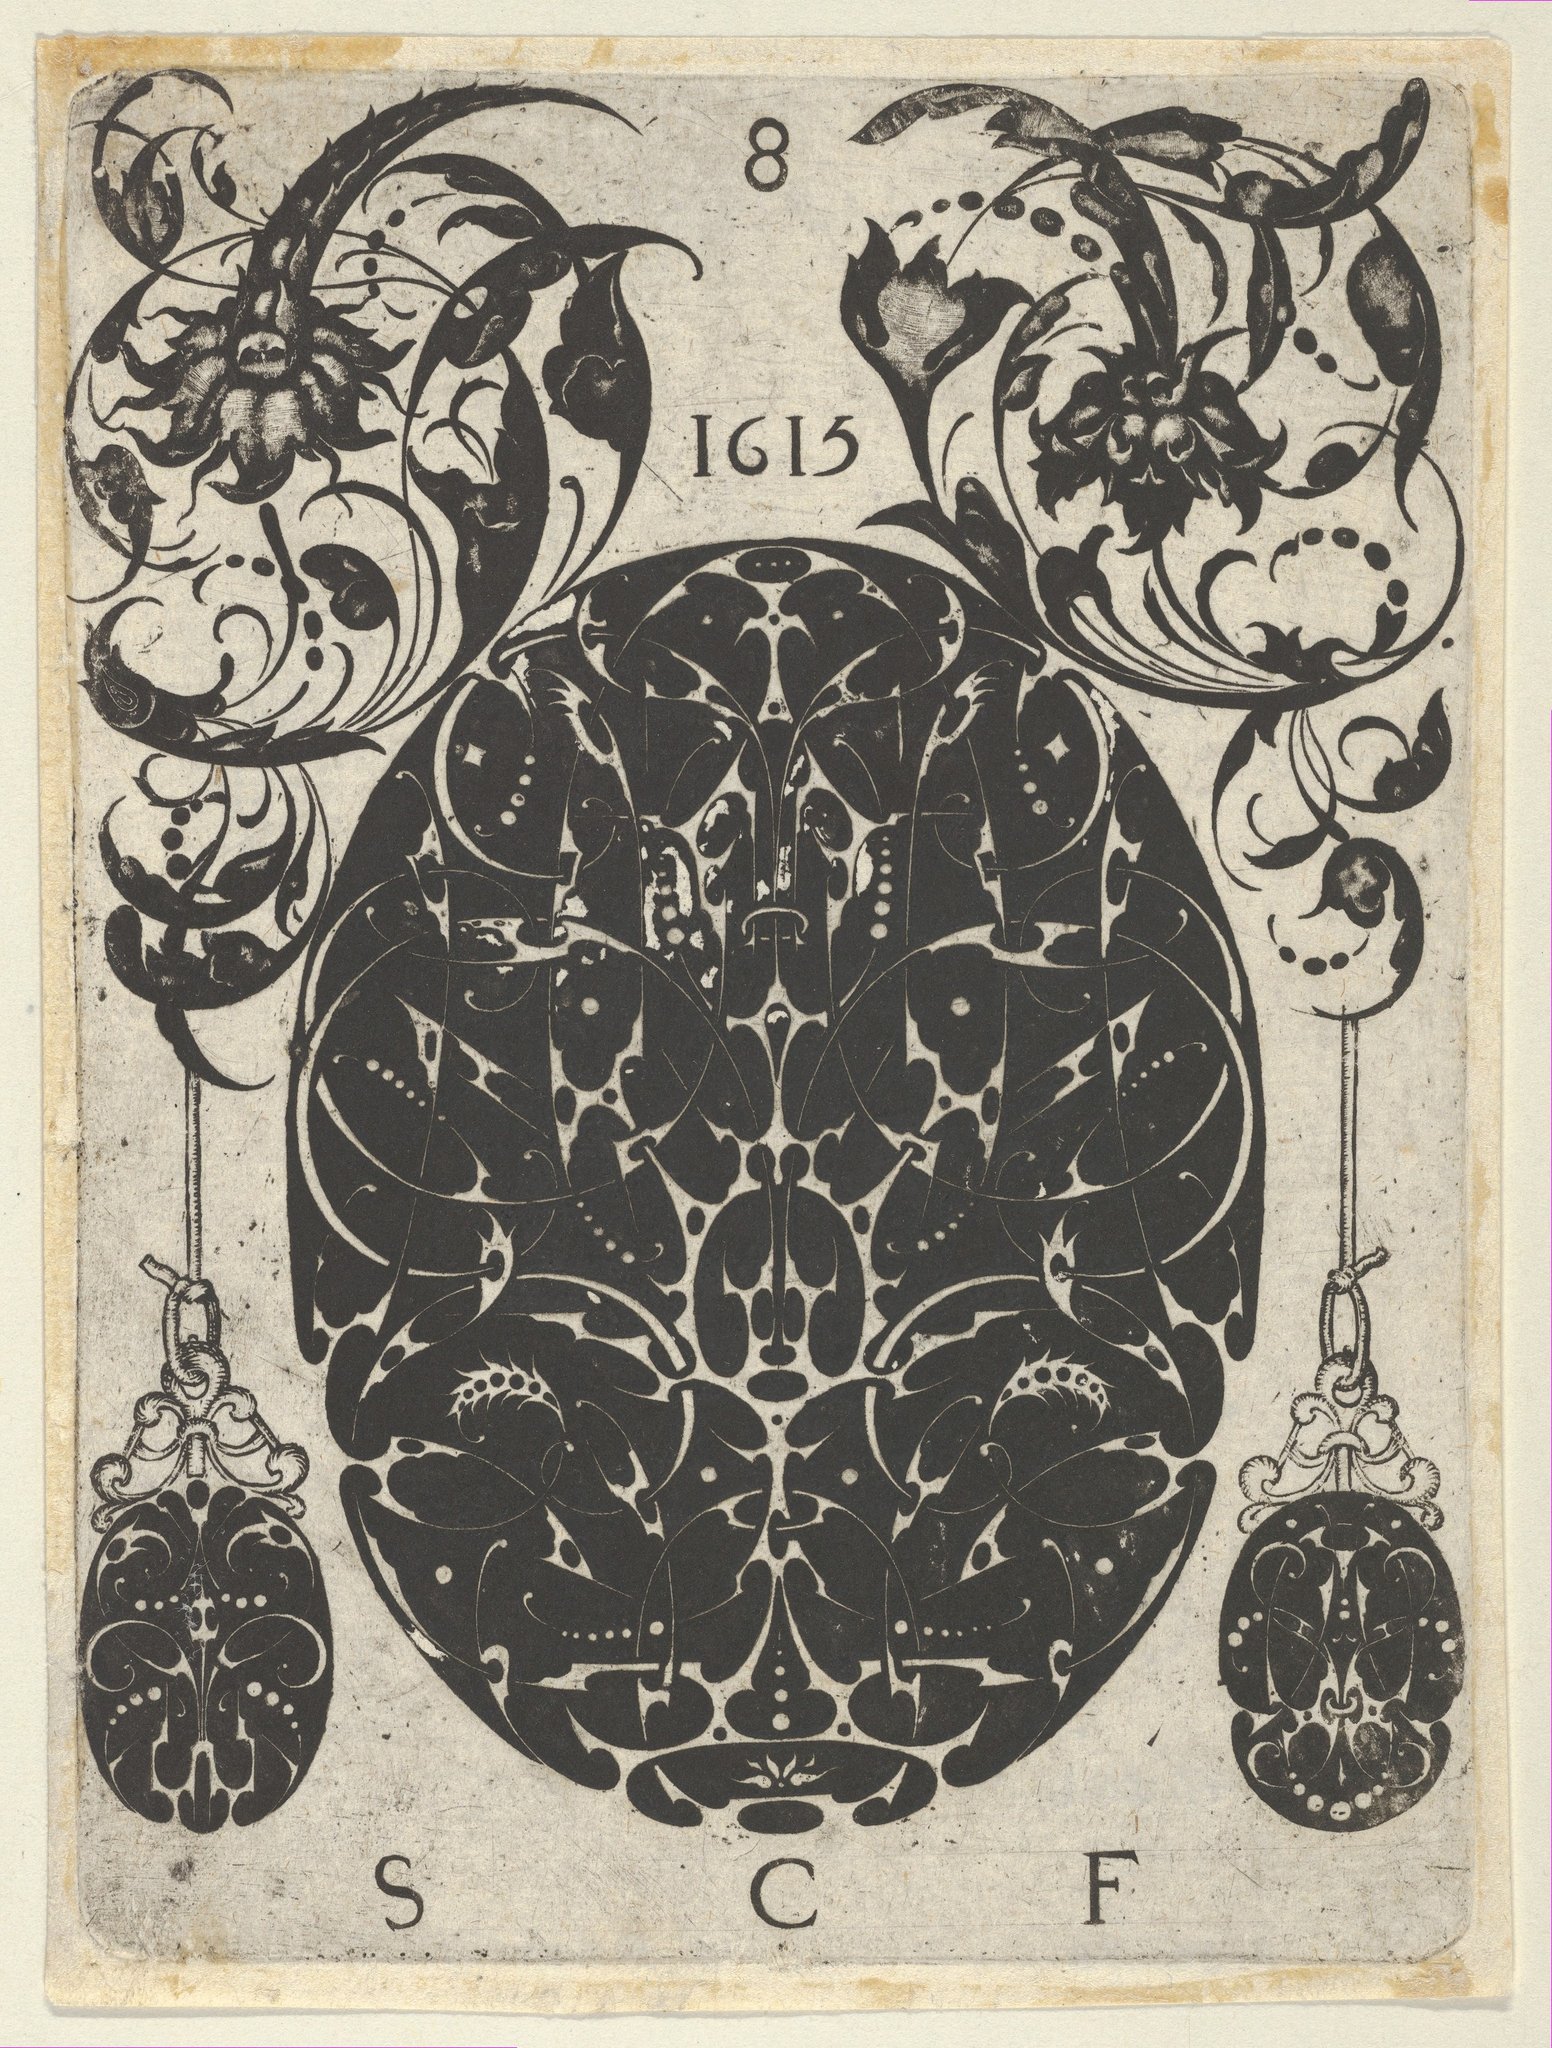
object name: print ornament architecture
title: Blackwork Print with an Oval at Center Flanked by Pendants Hanging from Foliate Scrolls, from a Series of Blackwork Prints for Goldsmiths' Work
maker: etienne carteron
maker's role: artist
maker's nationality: french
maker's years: 1580-1680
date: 1615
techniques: embroidery, engraving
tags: pendants